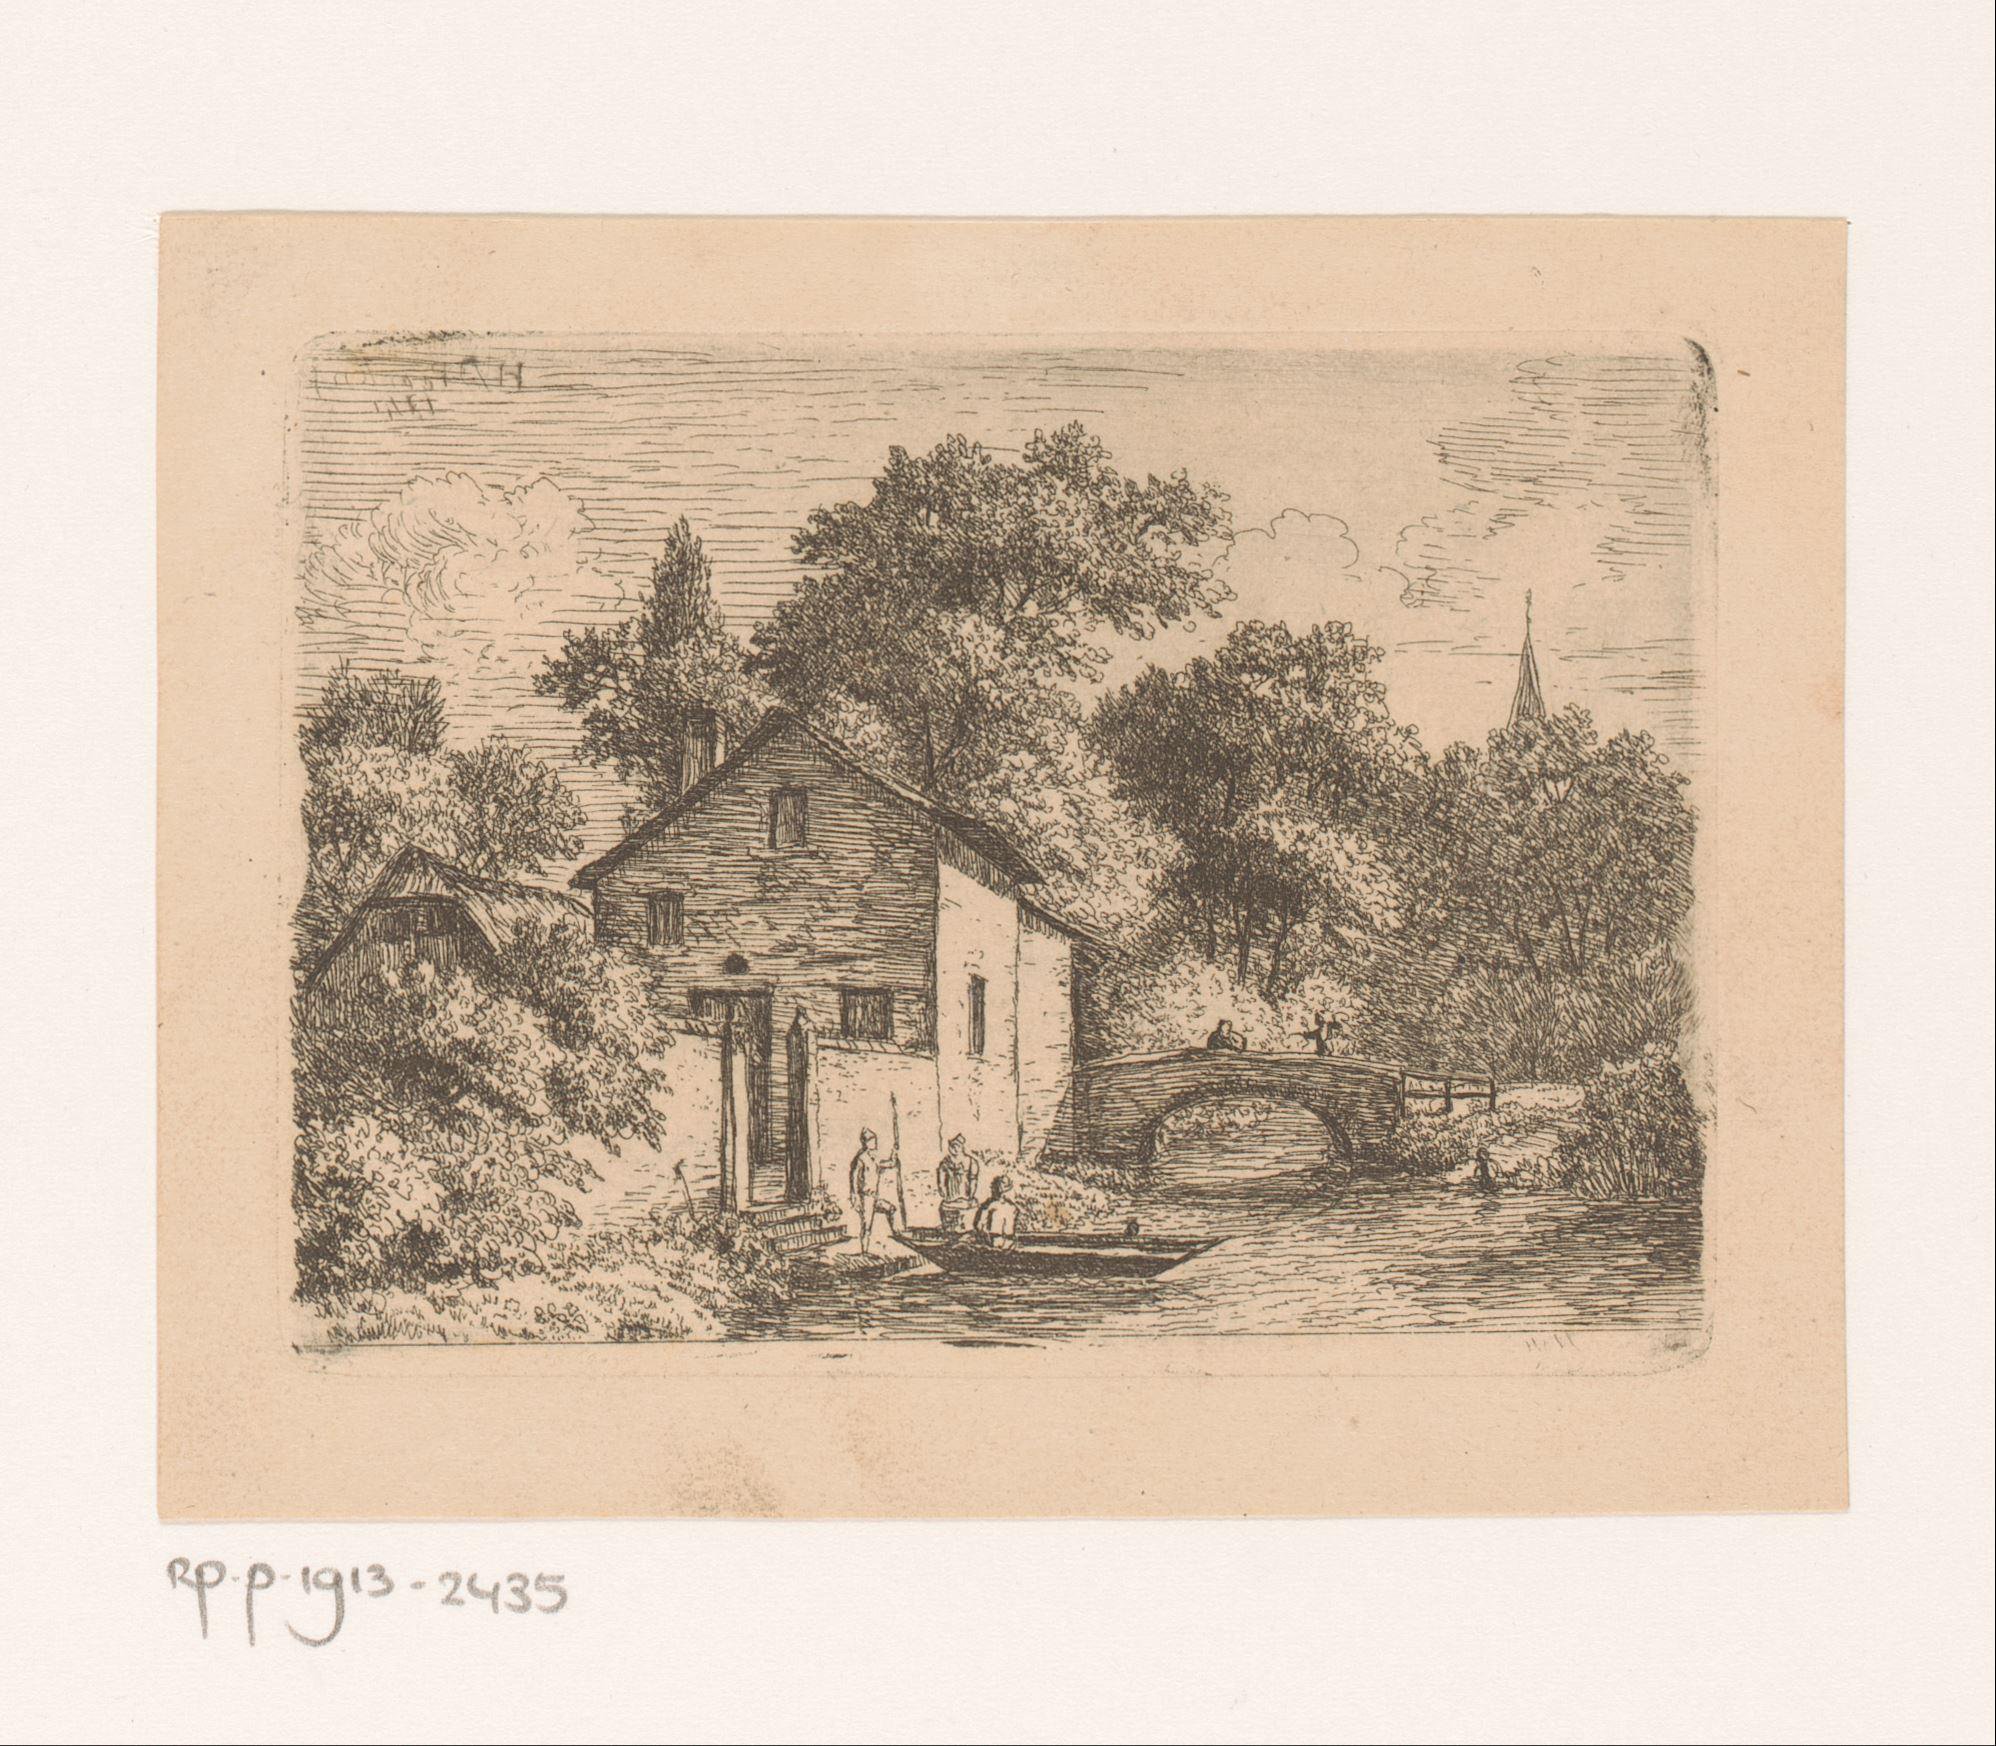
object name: print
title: Drie figuren bij een roeiboot voor een gebouw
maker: hendrik jozef franciscus van der poorten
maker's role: draughtsman, print maker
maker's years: 1789-1874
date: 1841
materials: paper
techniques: etching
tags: rowing-boat, canoe, etc., bridge in village across river, canal, etc.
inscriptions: collector's mark: Lugt 2228, collector's mark: Lugt 1485